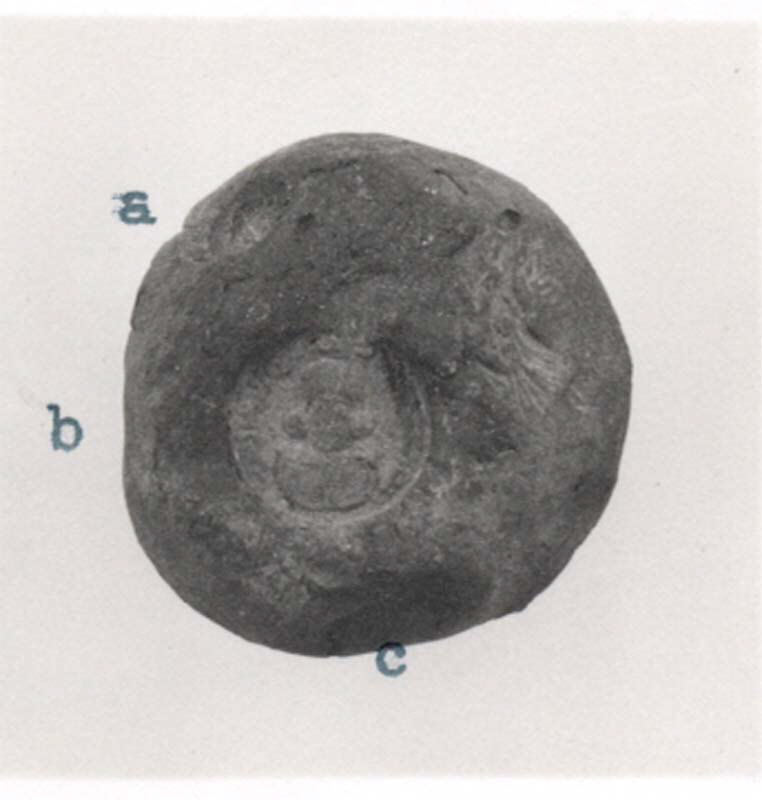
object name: sealing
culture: sasanian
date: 601-700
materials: clay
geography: iran